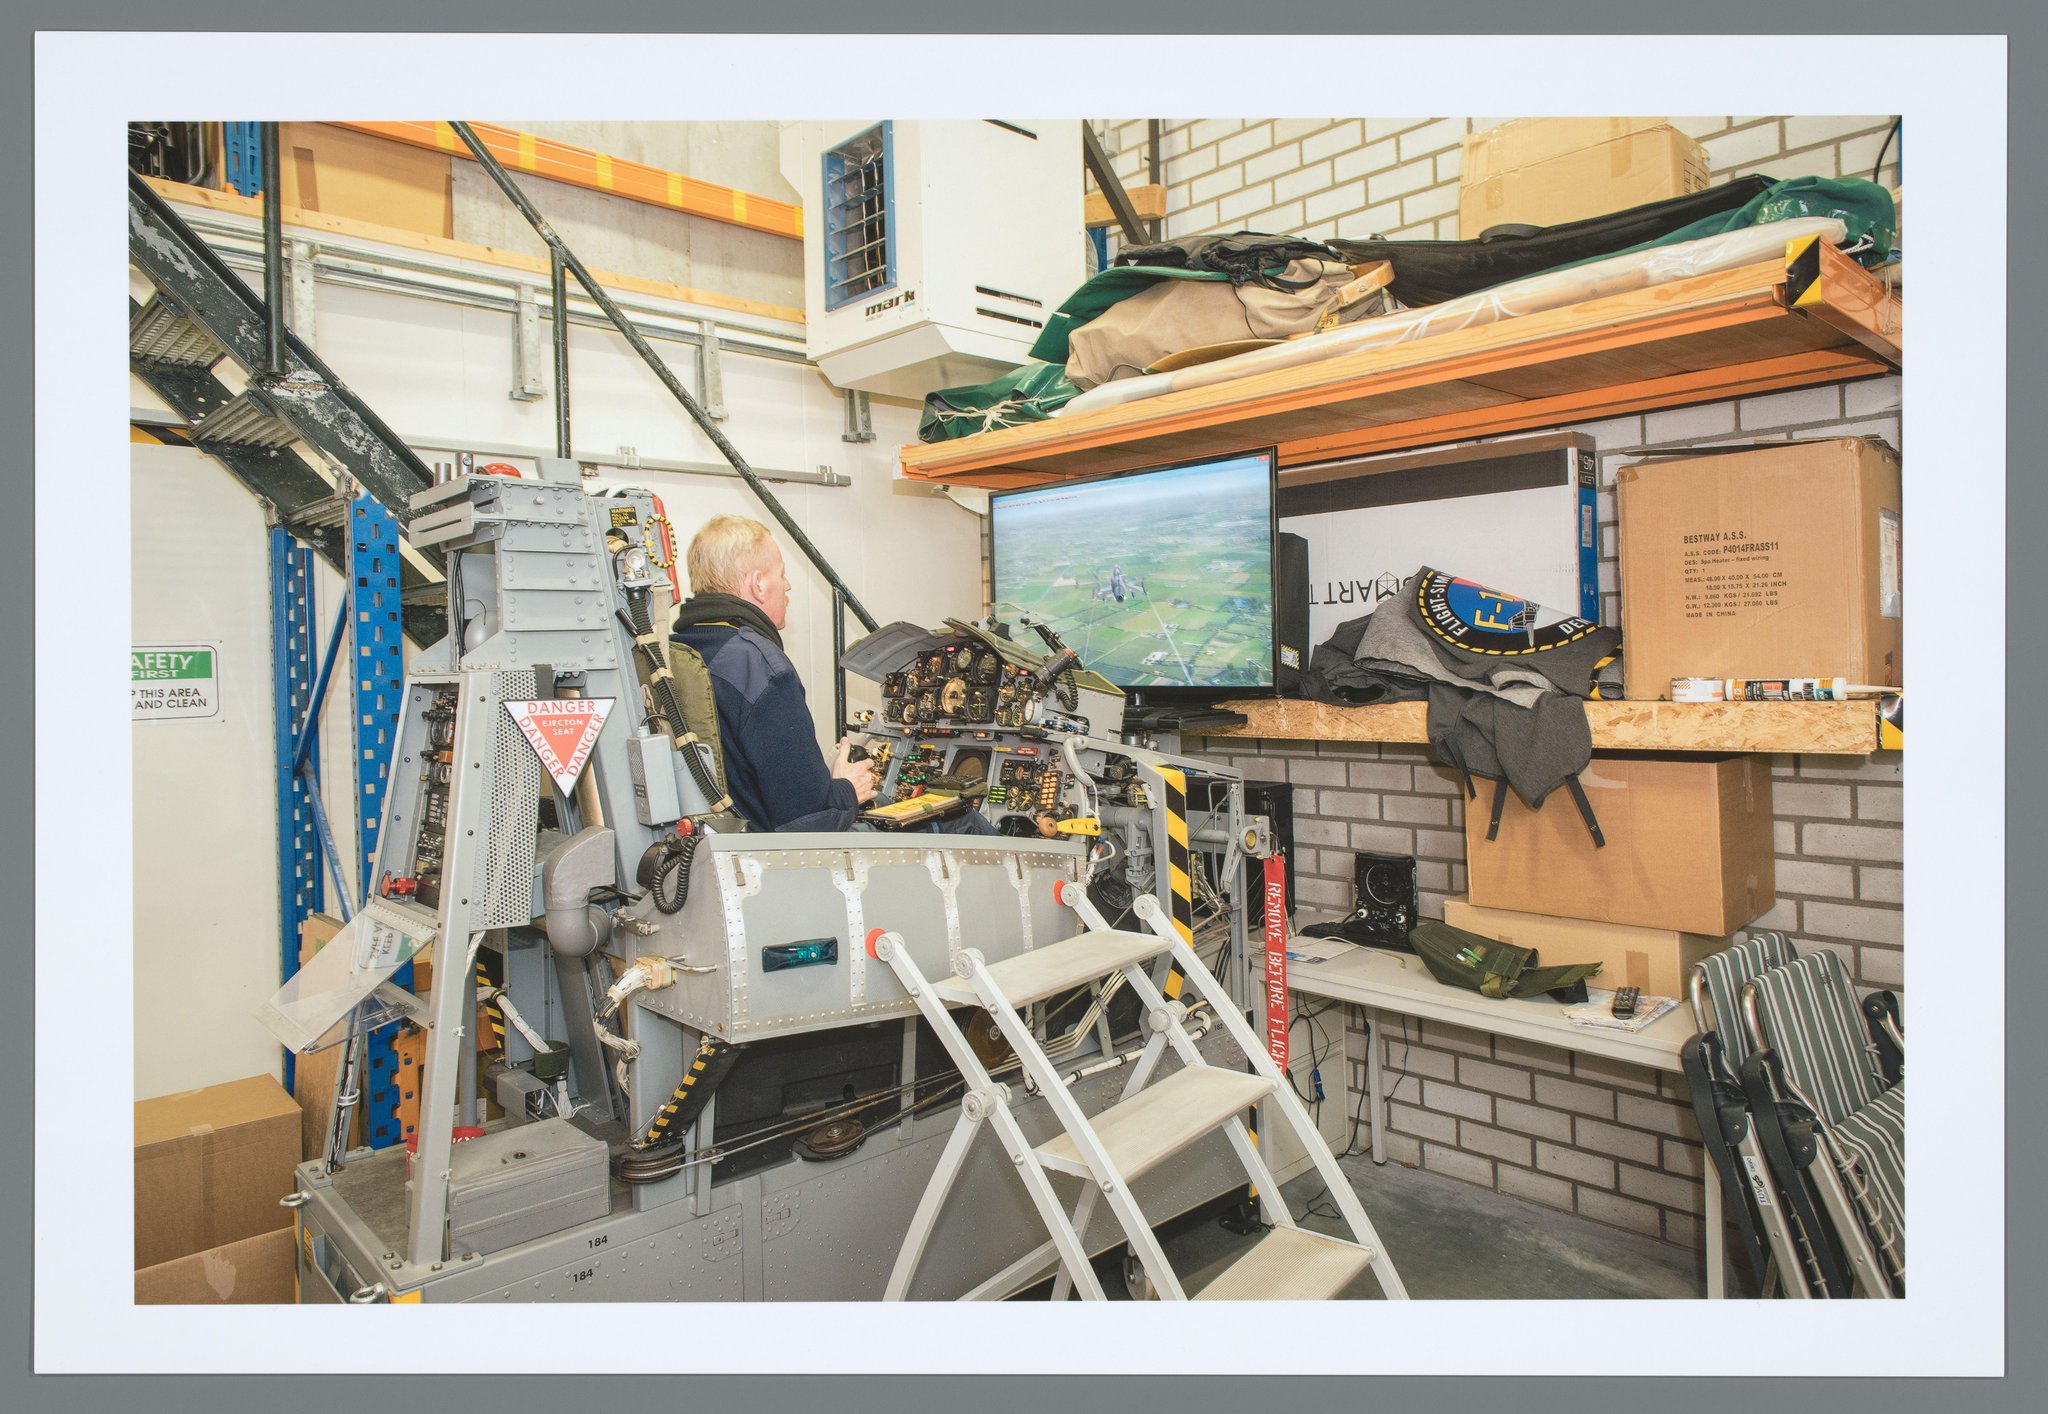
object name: photograph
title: Leon (53)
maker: gerrit meerman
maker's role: fotograaf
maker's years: 1957-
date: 2017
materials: ink, paper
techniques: inkjet print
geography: netherlands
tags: airborne traffic, aviation, computer, equation-solving machine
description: “Ik heb zeker 1000 uur moeten oefenen om er mee te kunnen vliegen”. Leon wilde als vijftienjarige niets liever dan piloot worden en ging op zijn zeventiende bij de luchtmacht. Omdat hij echter niet de juiste vooropleiding had, ging hij daar werken als kok. In die tijd toonde hij tevens zijn handigheid in het opknappen van defensiematerieel. Leon heeft nu een eigen zeilmakerij waarin een verzameling schietstoelen (30 stuks) en pilotenuitrustingen (72 stuks) is ondergebracht die hij zelf heeft gerestaureerd. De cockpit van een echte F104 Starfighter, die hij ook volledig gerestaureerd heeft, is omgebouwd tot flightsimulator. Leon heeft eerst avonden moeten oefenen om alleen maar te kunnen taxiën, daarna zeker nog eens 1000 uur om te kunnen vliegen. Nu oefent hij iedere zondagavond en draagt daarbij echte pilotenhandschoenen wat het vliegen een stuk moeilijker maakt.